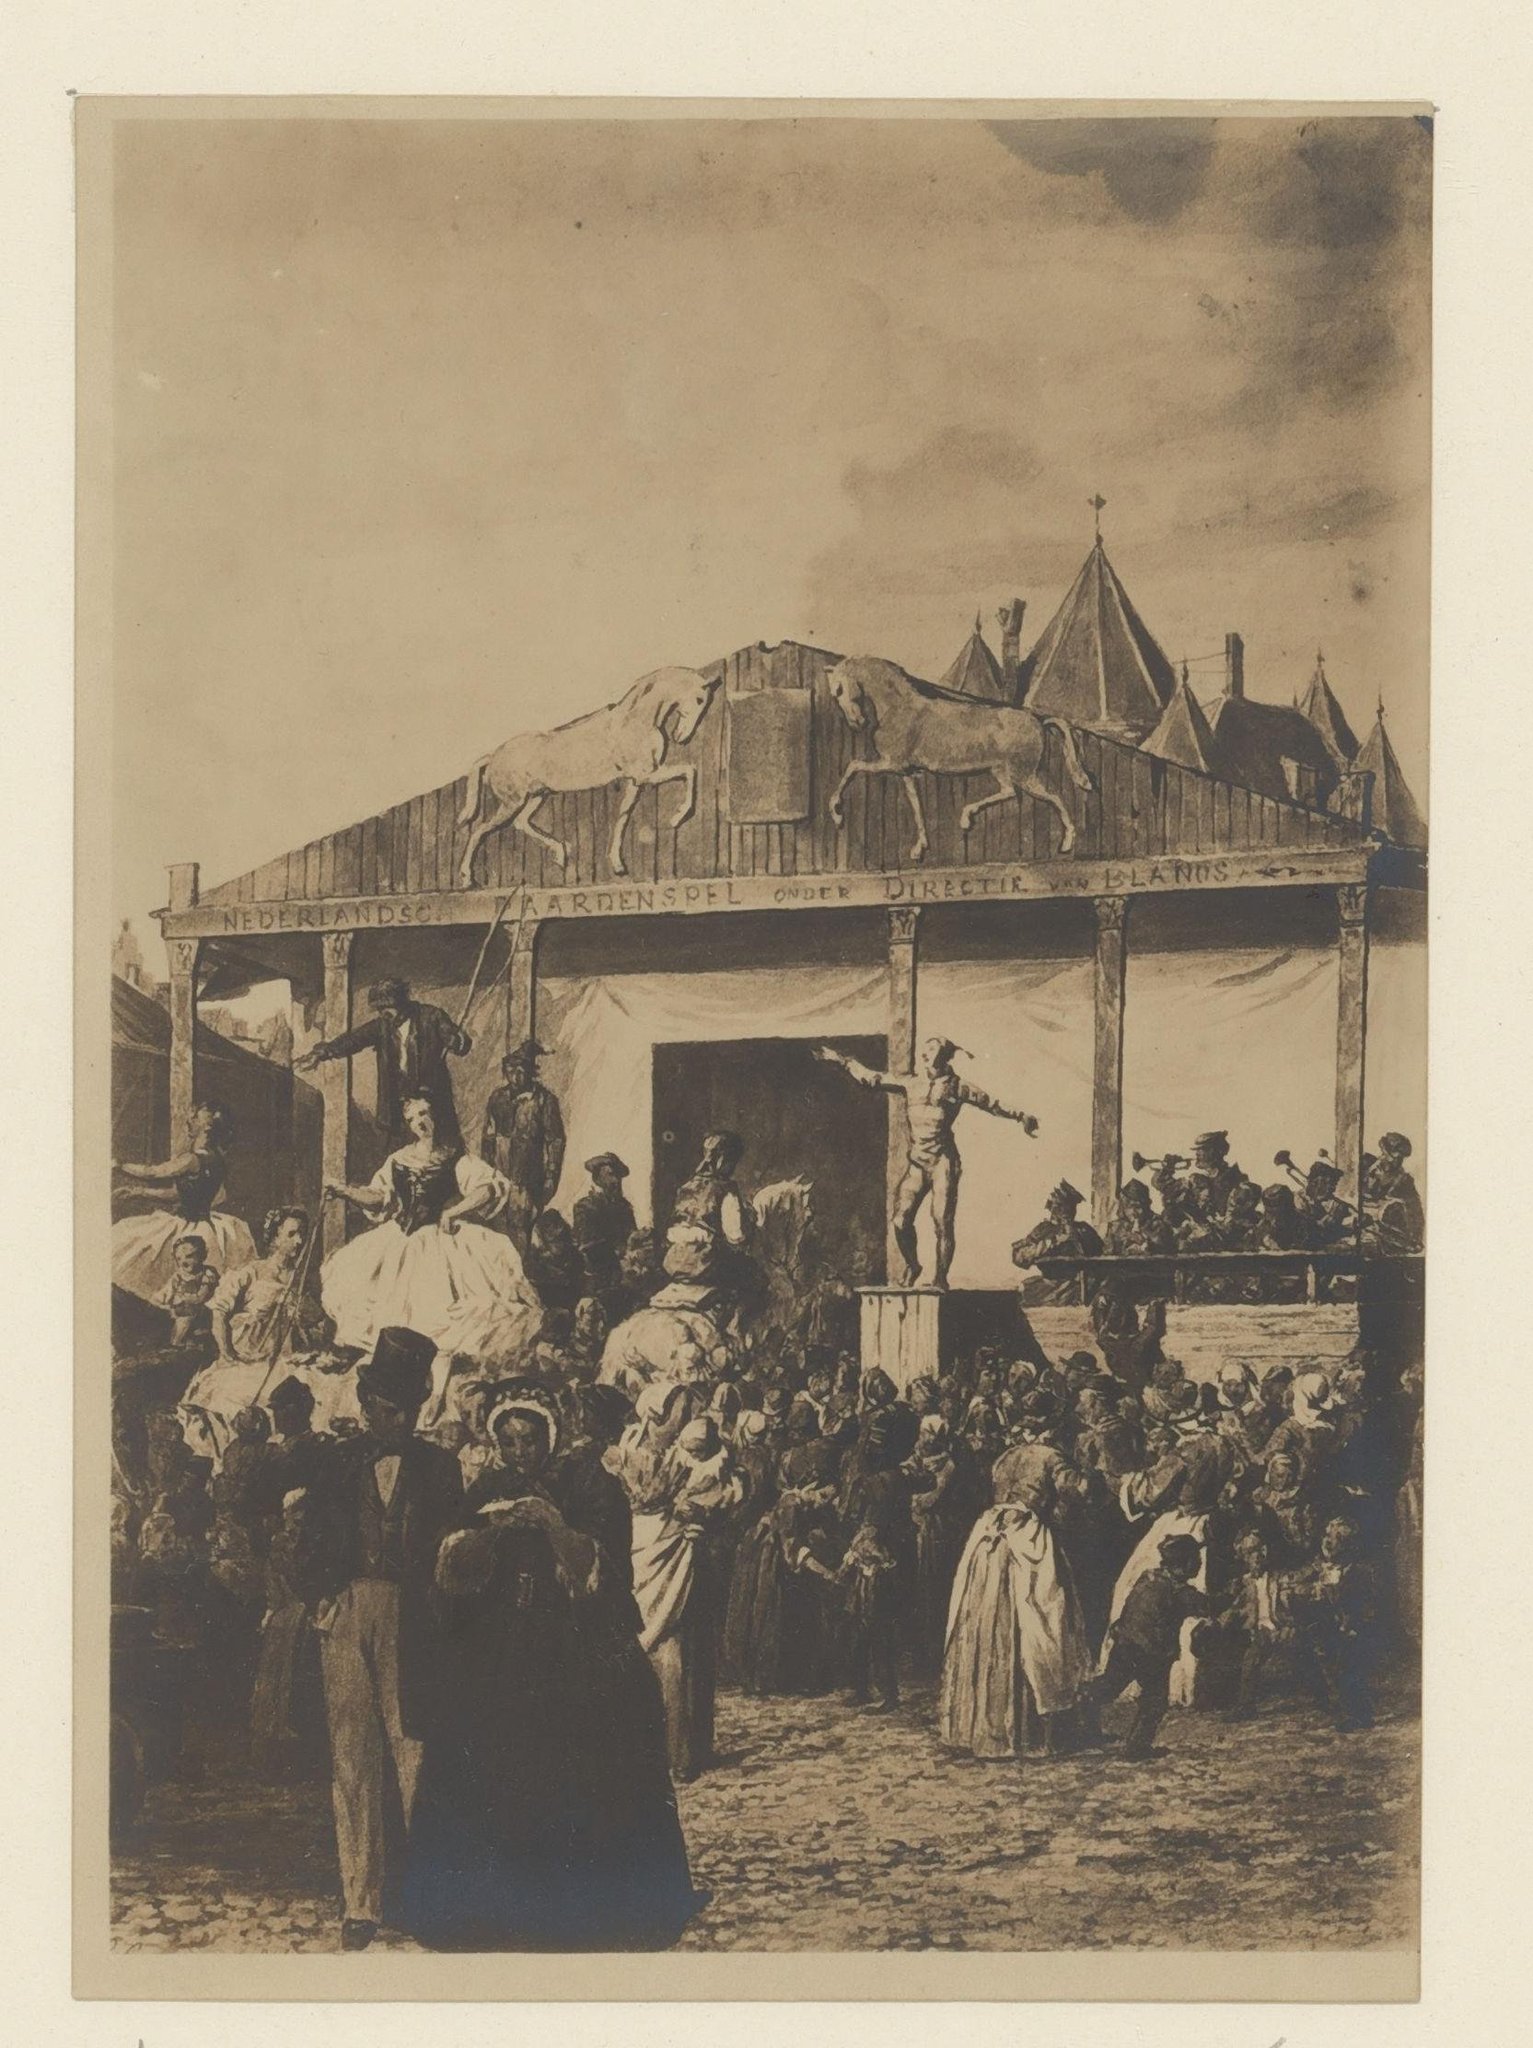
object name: photograph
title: Fotoreproductie van een aquarel van de kermis op de Nieuwmarkt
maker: Anonymous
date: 1875-1925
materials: photographic support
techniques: gelatin silver print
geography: netherlands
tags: pleasure fair and circus, horses (circus performance)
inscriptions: collector's mark: Lugt 1641, collector's mark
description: Foto van een aquarel van het paardenspel van Blanus op de kermis op de Nieuwmarkt, in 1866 of 1867. Aquarel in de collectie van het Stadsarchief te Amsterdam. Onderwerpsrubrieken binnen de Atlas Zeden en Gewoonten: Volksfeesten; Kermis.